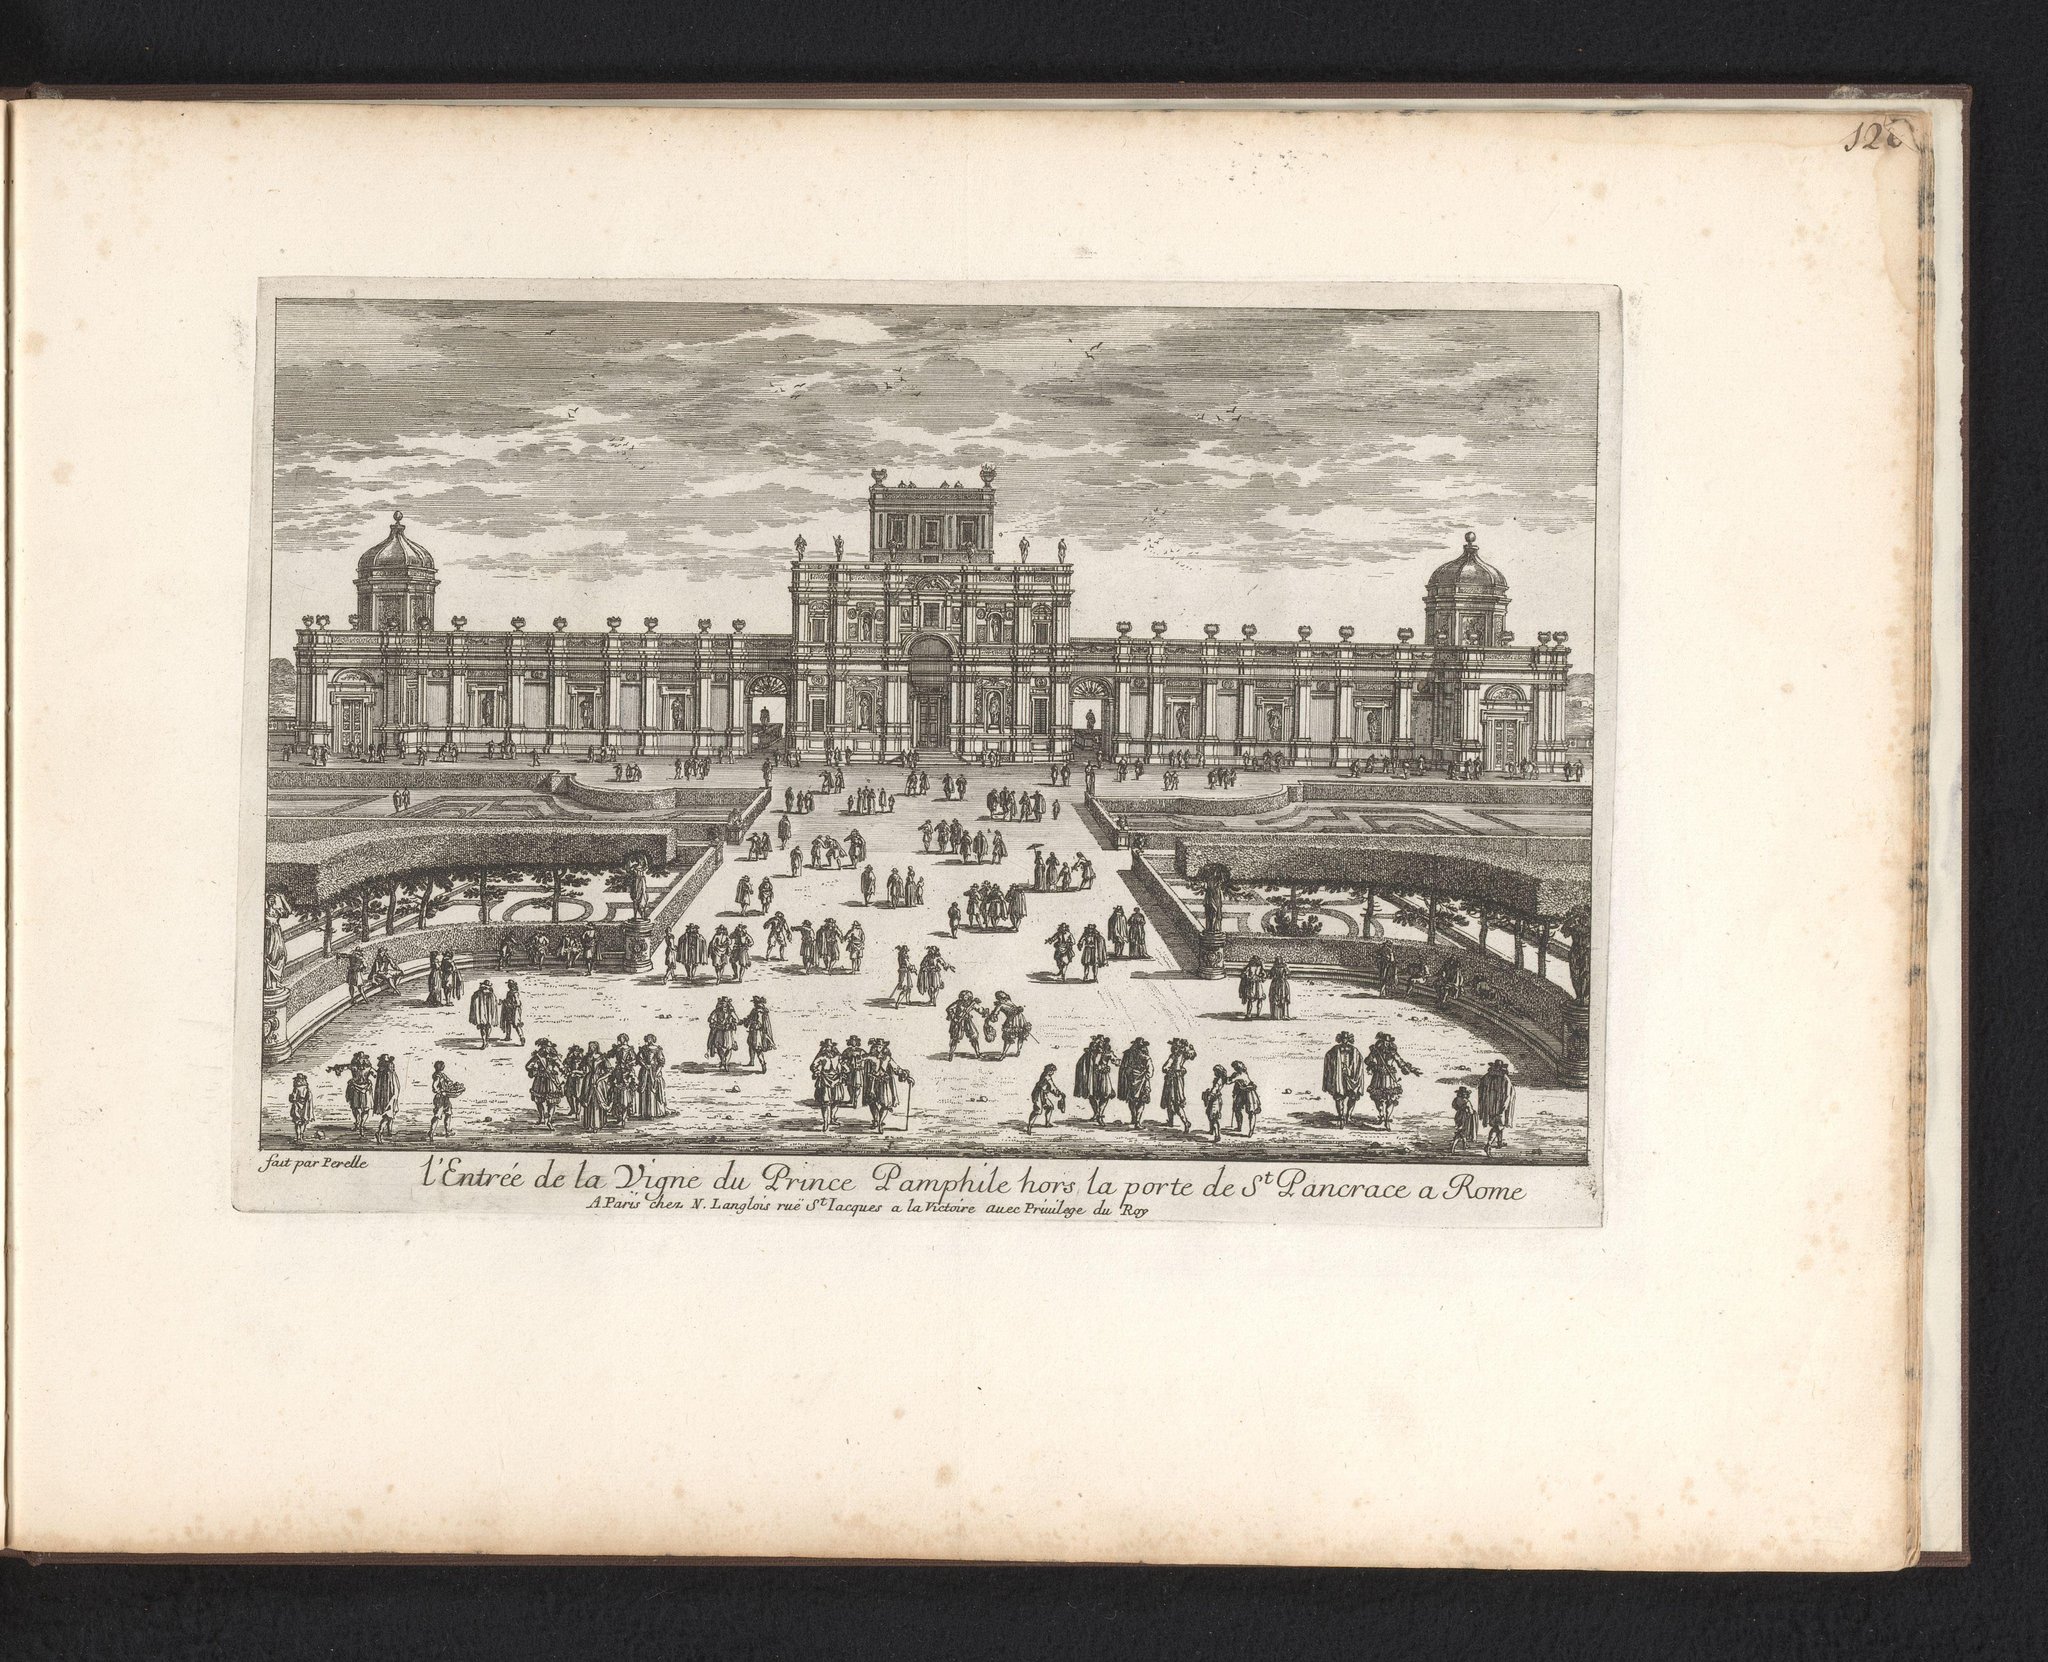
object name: print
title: L'Entrée de la Vigne du Prince Pamphile hors la porte de St. Pancrace a Rome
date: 1650-1695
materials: paper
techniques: etching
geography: paris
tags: villa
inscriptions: collector's mark: Lugt 2228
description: Prenten met het signatuur 'Perelle' kunnen zowel door vader Gabriel als door zonen Nicolas en Adam gemaakt zijn. De uitgevers vader en zoon Nicolas Langlois worden allebei vermeld als N. Langlois op hetzelfde adres.